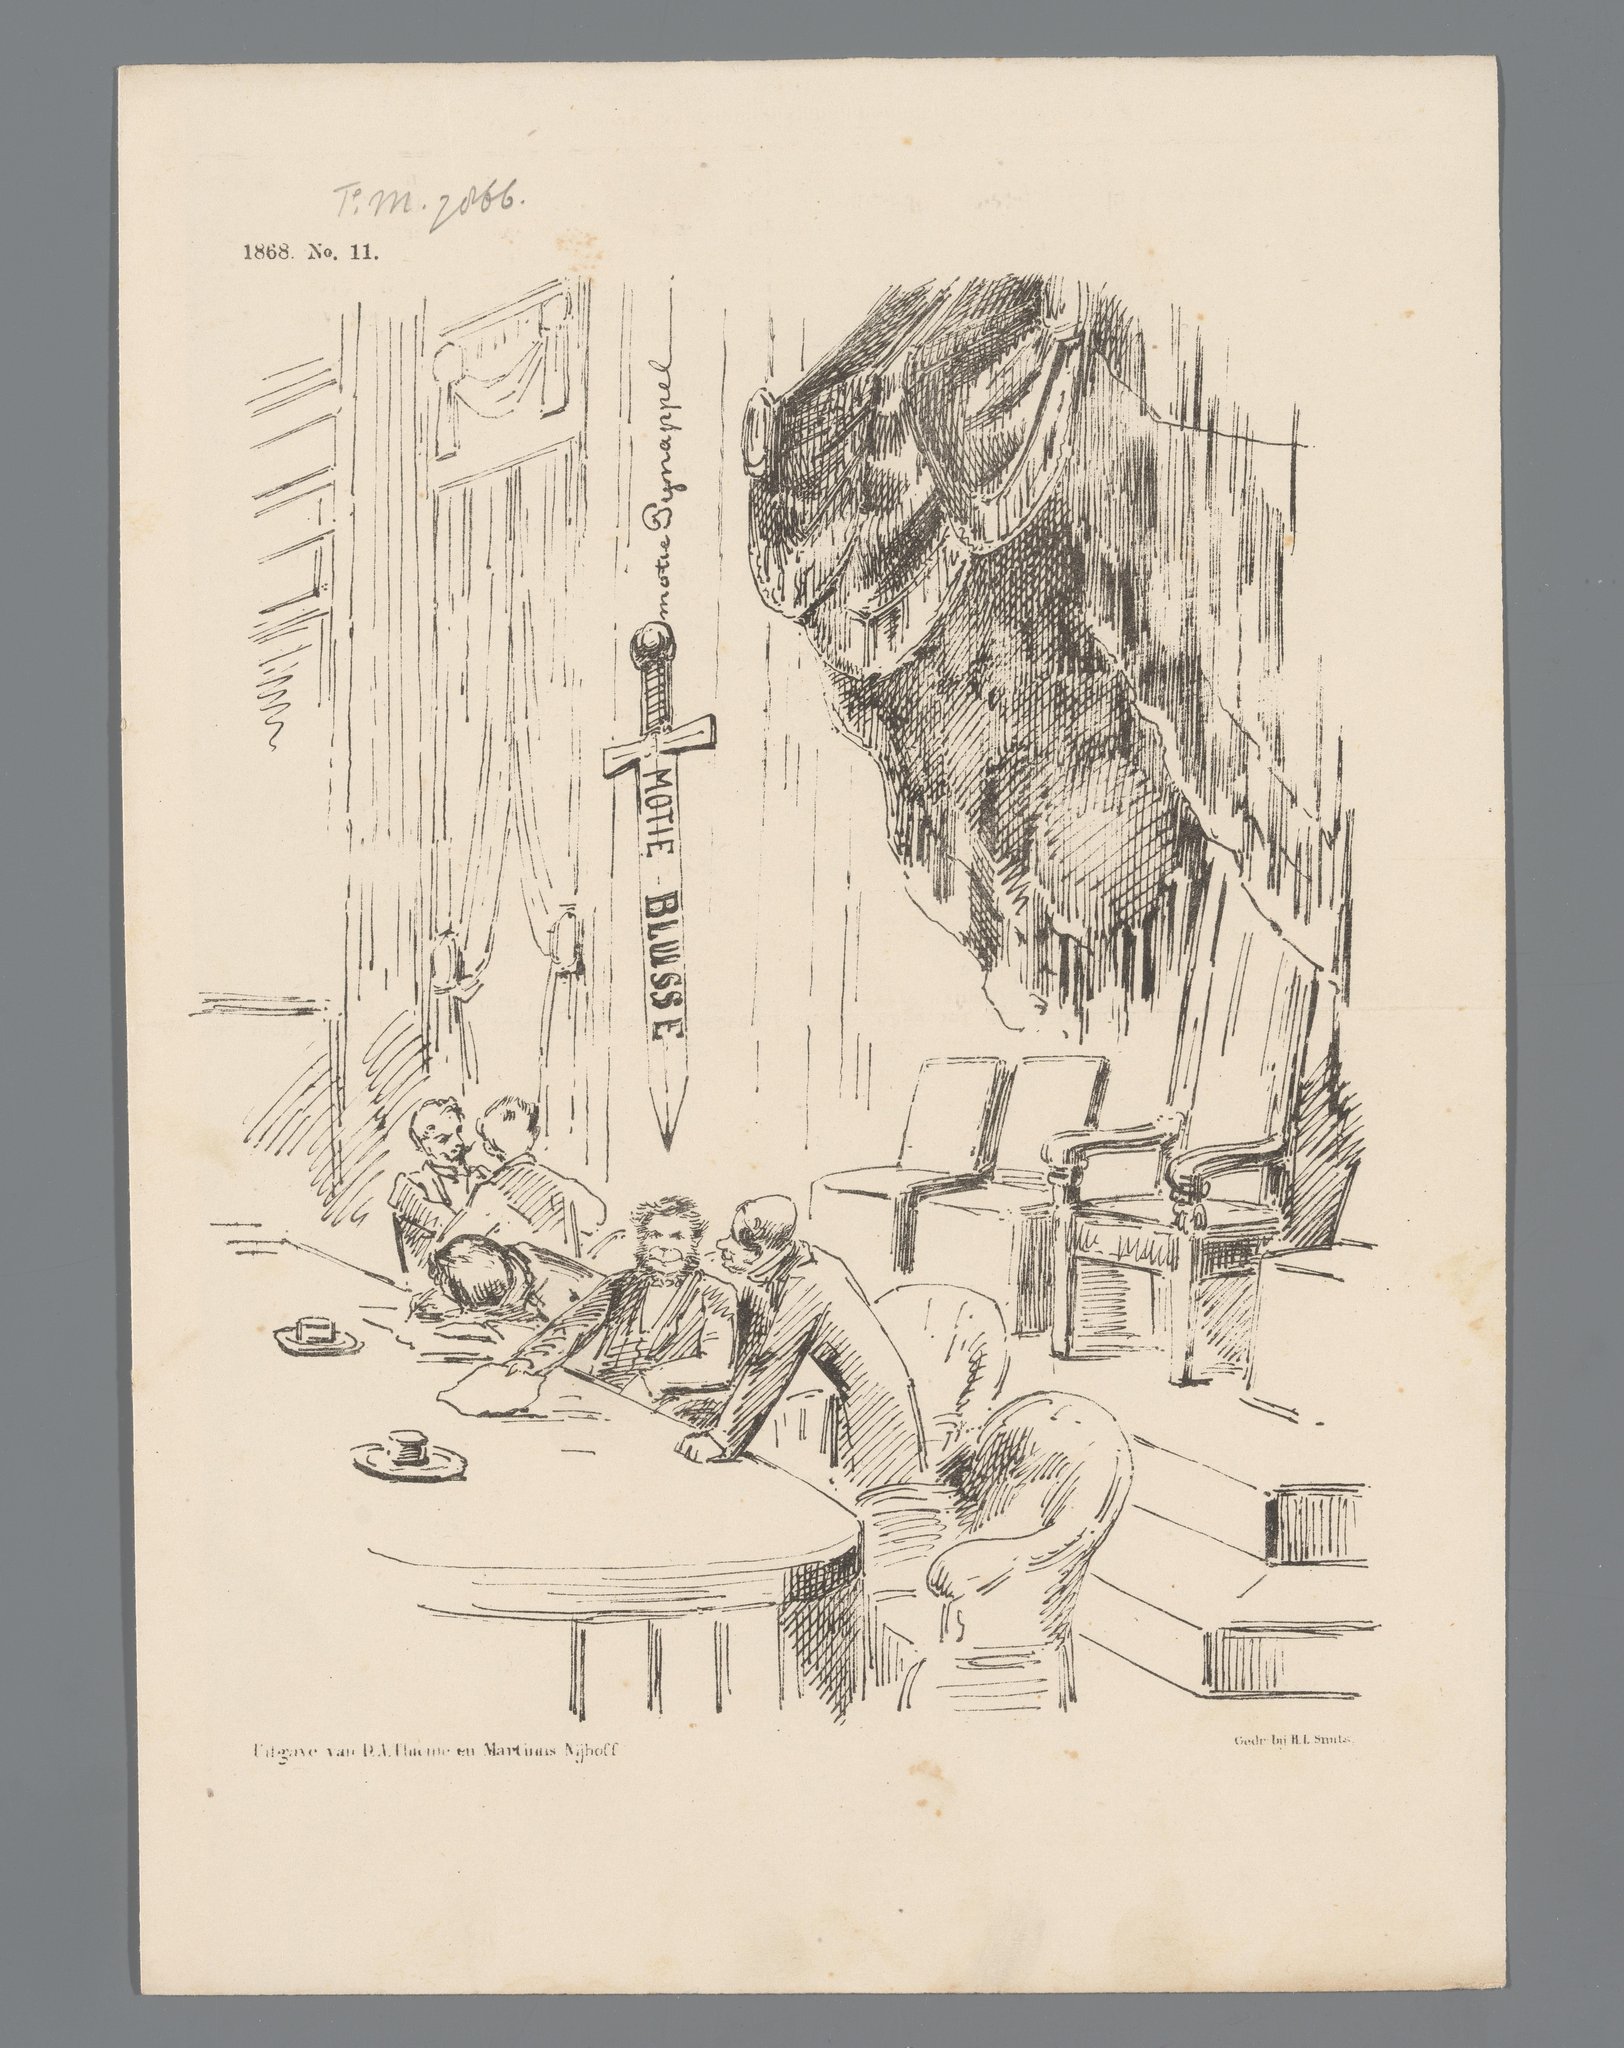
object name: print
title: Spotprent op minister Van Zuylen, 1868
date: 1867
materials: paper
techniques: lithograph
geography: the hague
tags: earl, minister ~ government, sword of damocles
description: Spotprent op minister Van Zuylen boven wiens hoofd in de Tweede Kamer het zwaard van Damocles aan een zijden draad hangt. Plaat verschenen bij het weekblad De Nederlandsche Spectator, nr. 11, 14 maart 1868.